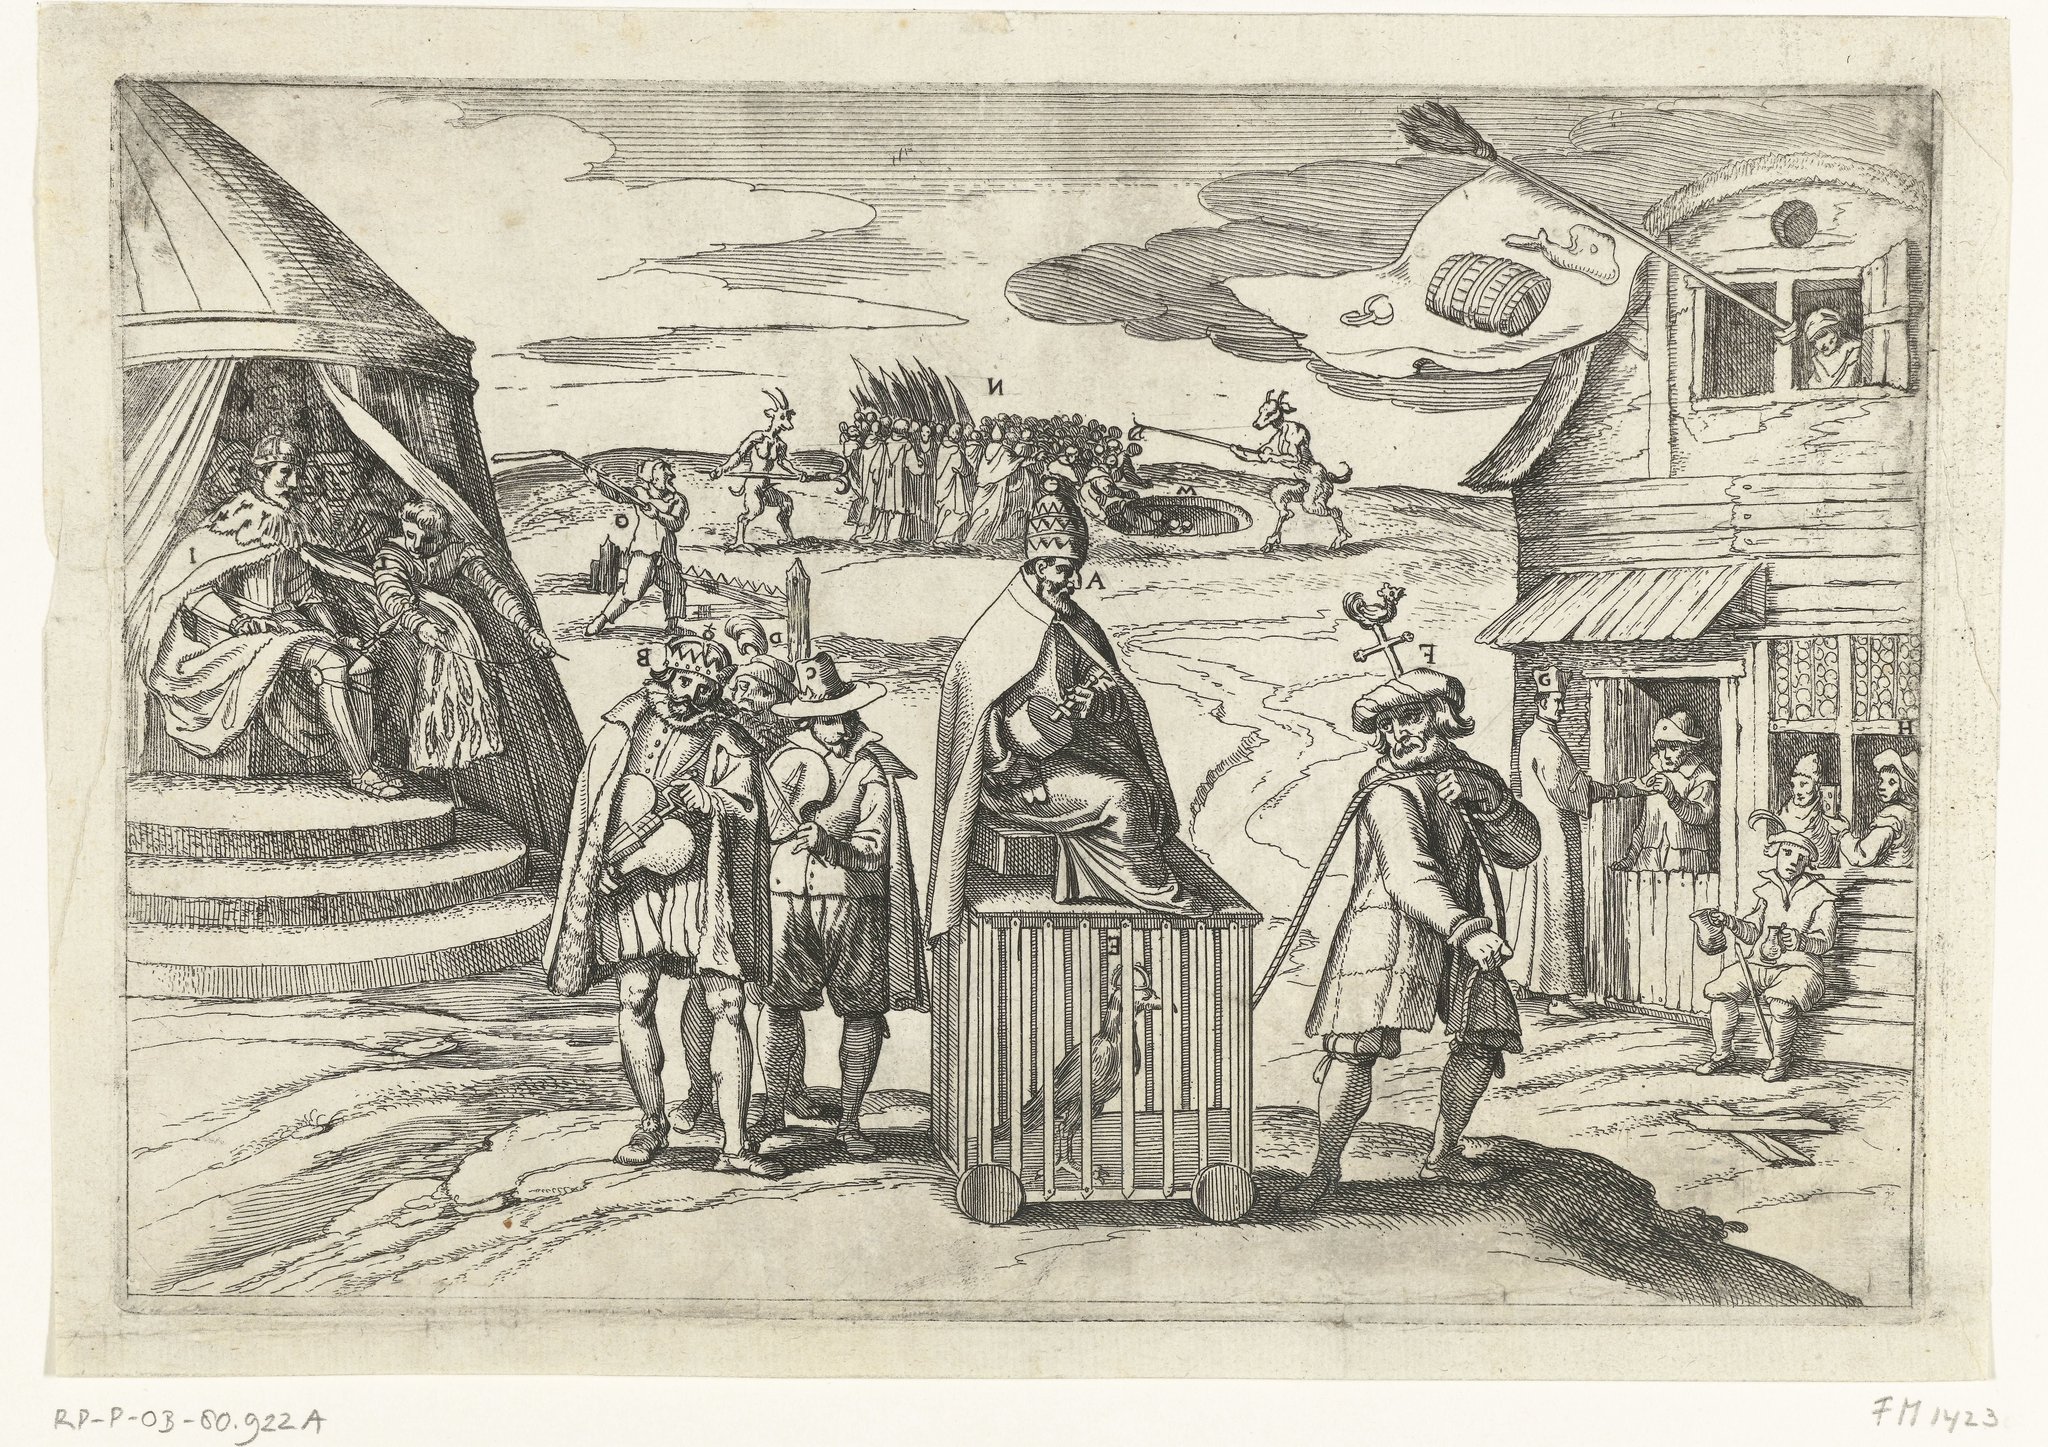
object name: print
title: De Roomse Roffel-Pot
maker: Anonymous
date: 1620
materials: paper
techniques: etching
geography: low countries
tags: vienna, ferdinand ii (duits keizer), amberg, frederik v (keurvorst van de palts, koning van bohemen), other percussion instruments, improvised musical instruments: rumbling pot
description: De Roomse roffelpot. Spotprent op de verliezen van de paus en de Duitse keizer Ferdinand II en op de voordelen van Frederik, koning van Bohemen. De keurvorst van Saksen trekt een kar met een kooi met de kaalgeplukte adelaar, bovenop zit de paus met een rommelpot. Hierbij een groepje muzikanten met de keizer, een jezuïet en Spinola. Links krijgt Frederik de veren aan zijn mantel genaaid, rechts een herberg met bezoekers die de taferelen bespreken. Bij de prent behoort een los tekstblad met een samenspreking tussen twee boeren en een boekverkoper en de legenda A-O in 3 kolommen in het Nederlands.